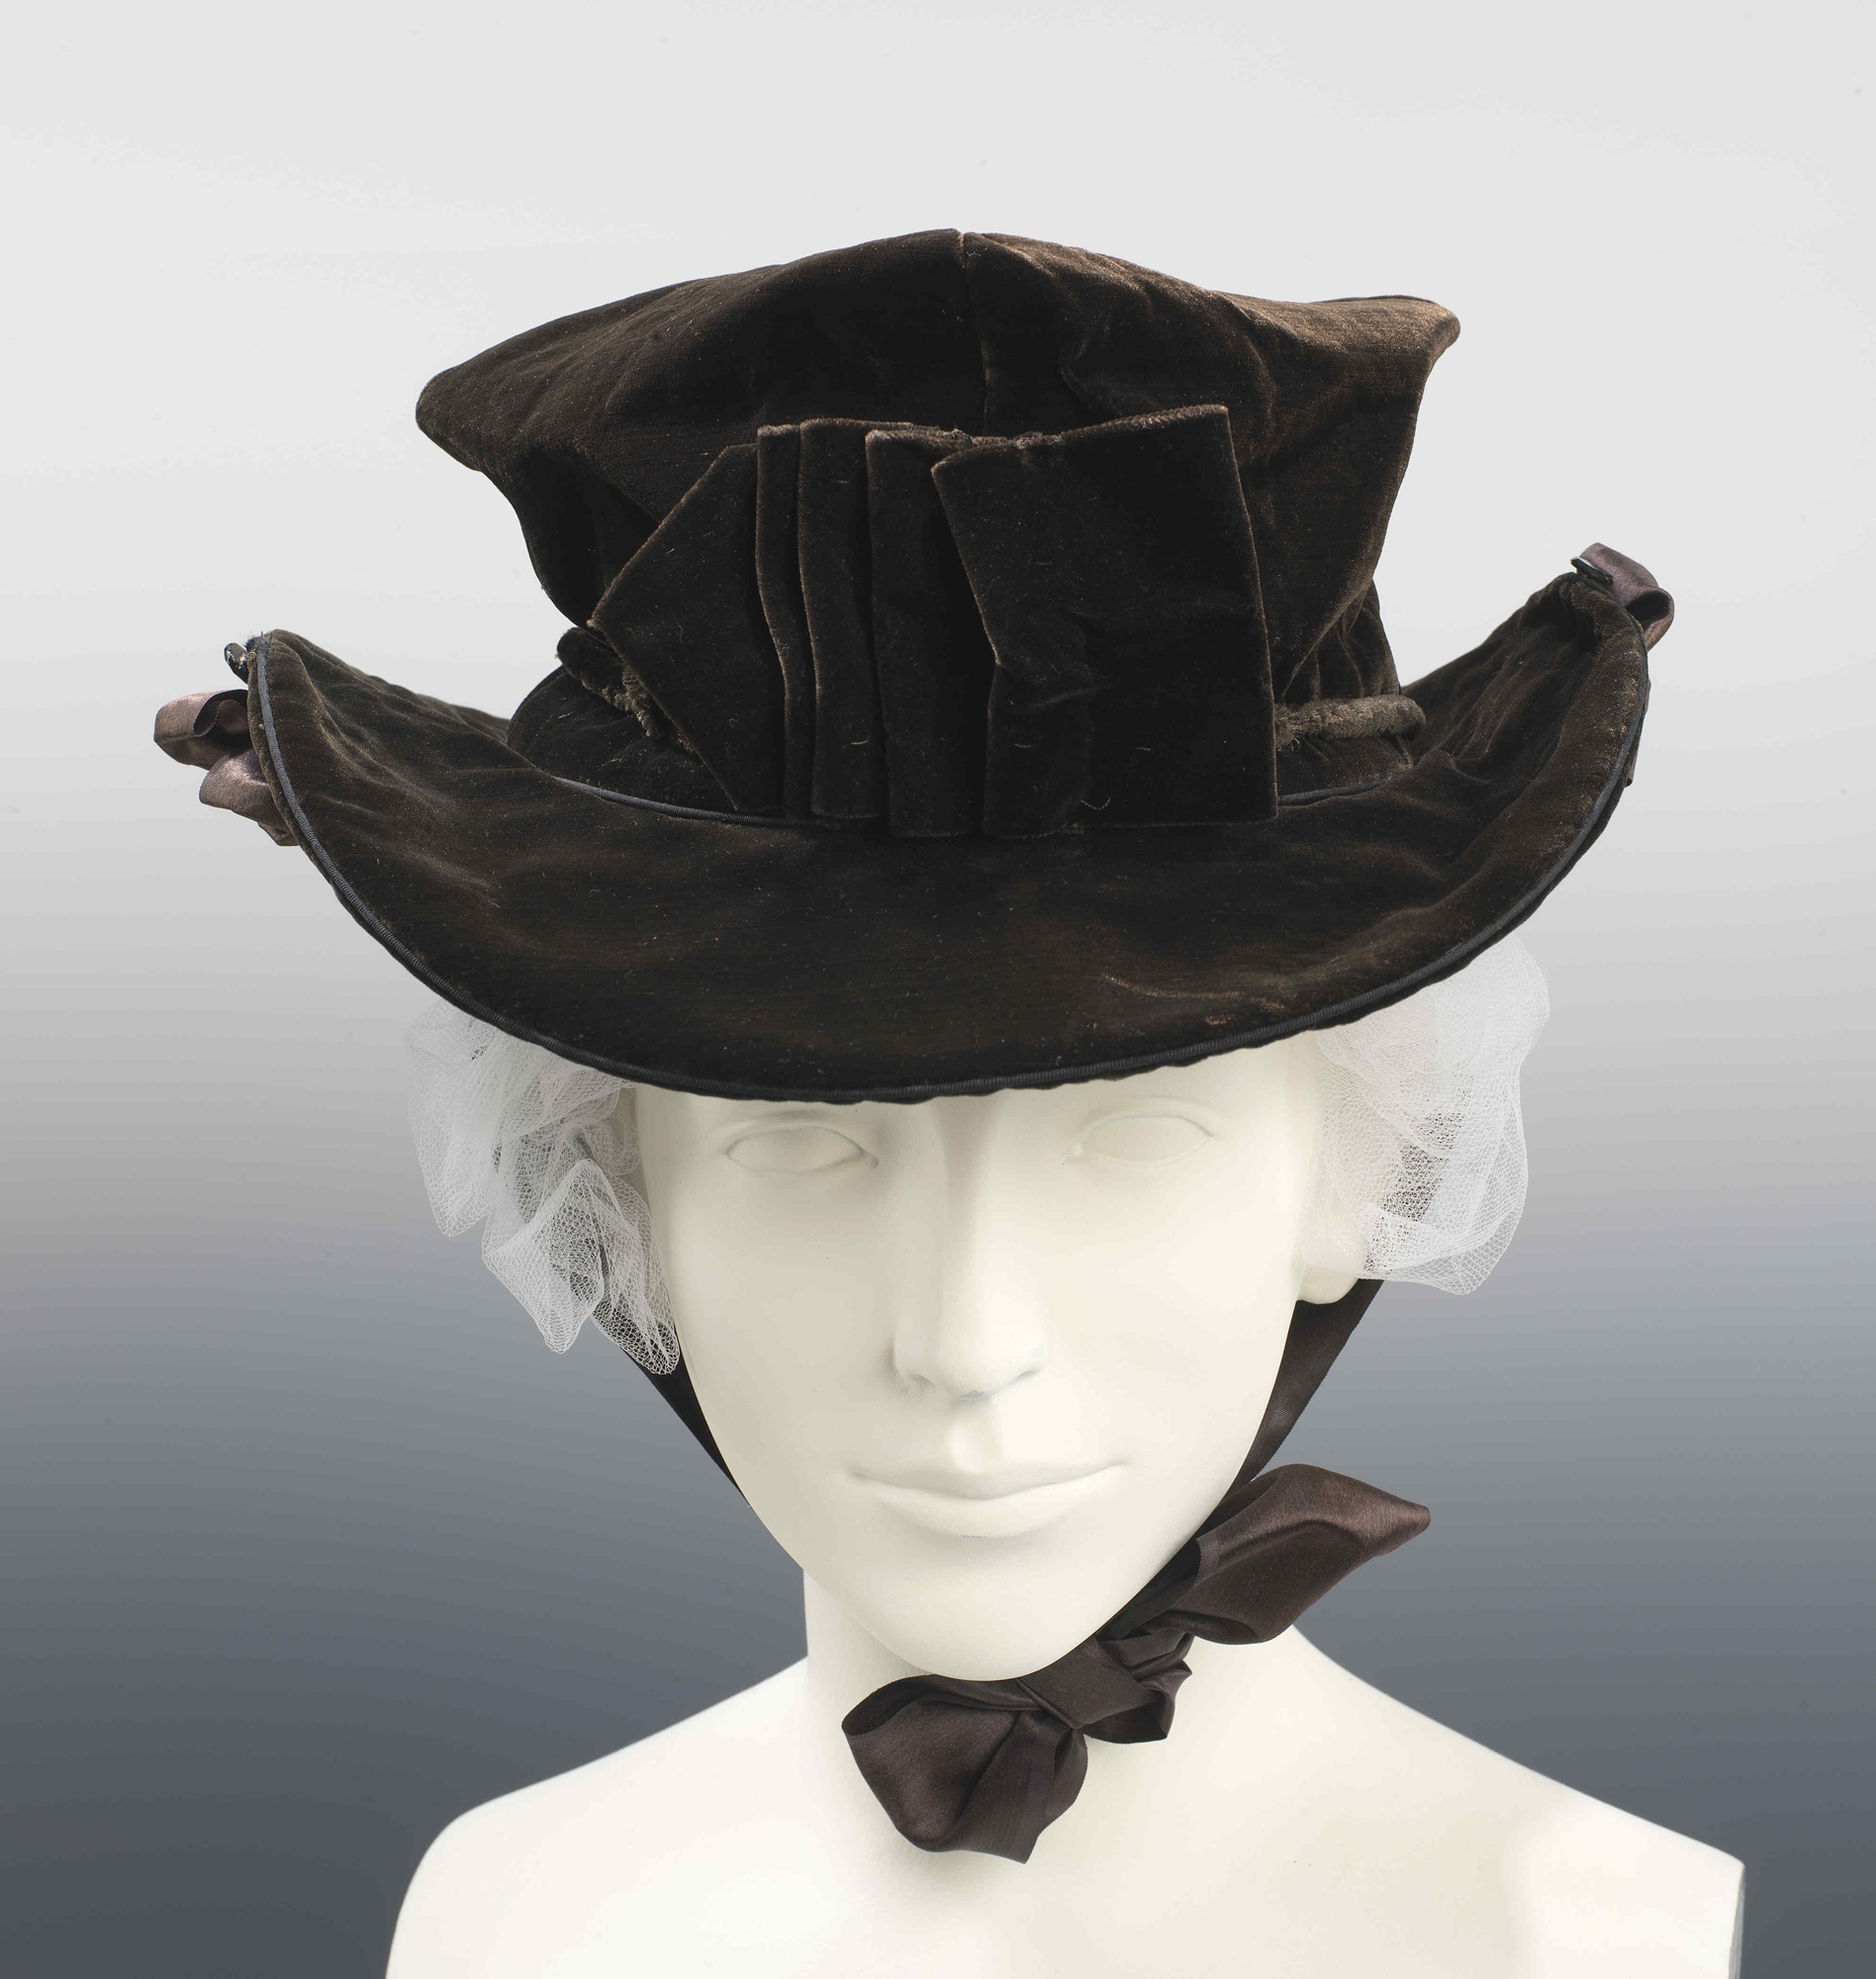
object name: hat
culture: american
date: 1810-1815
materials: cotton, silk